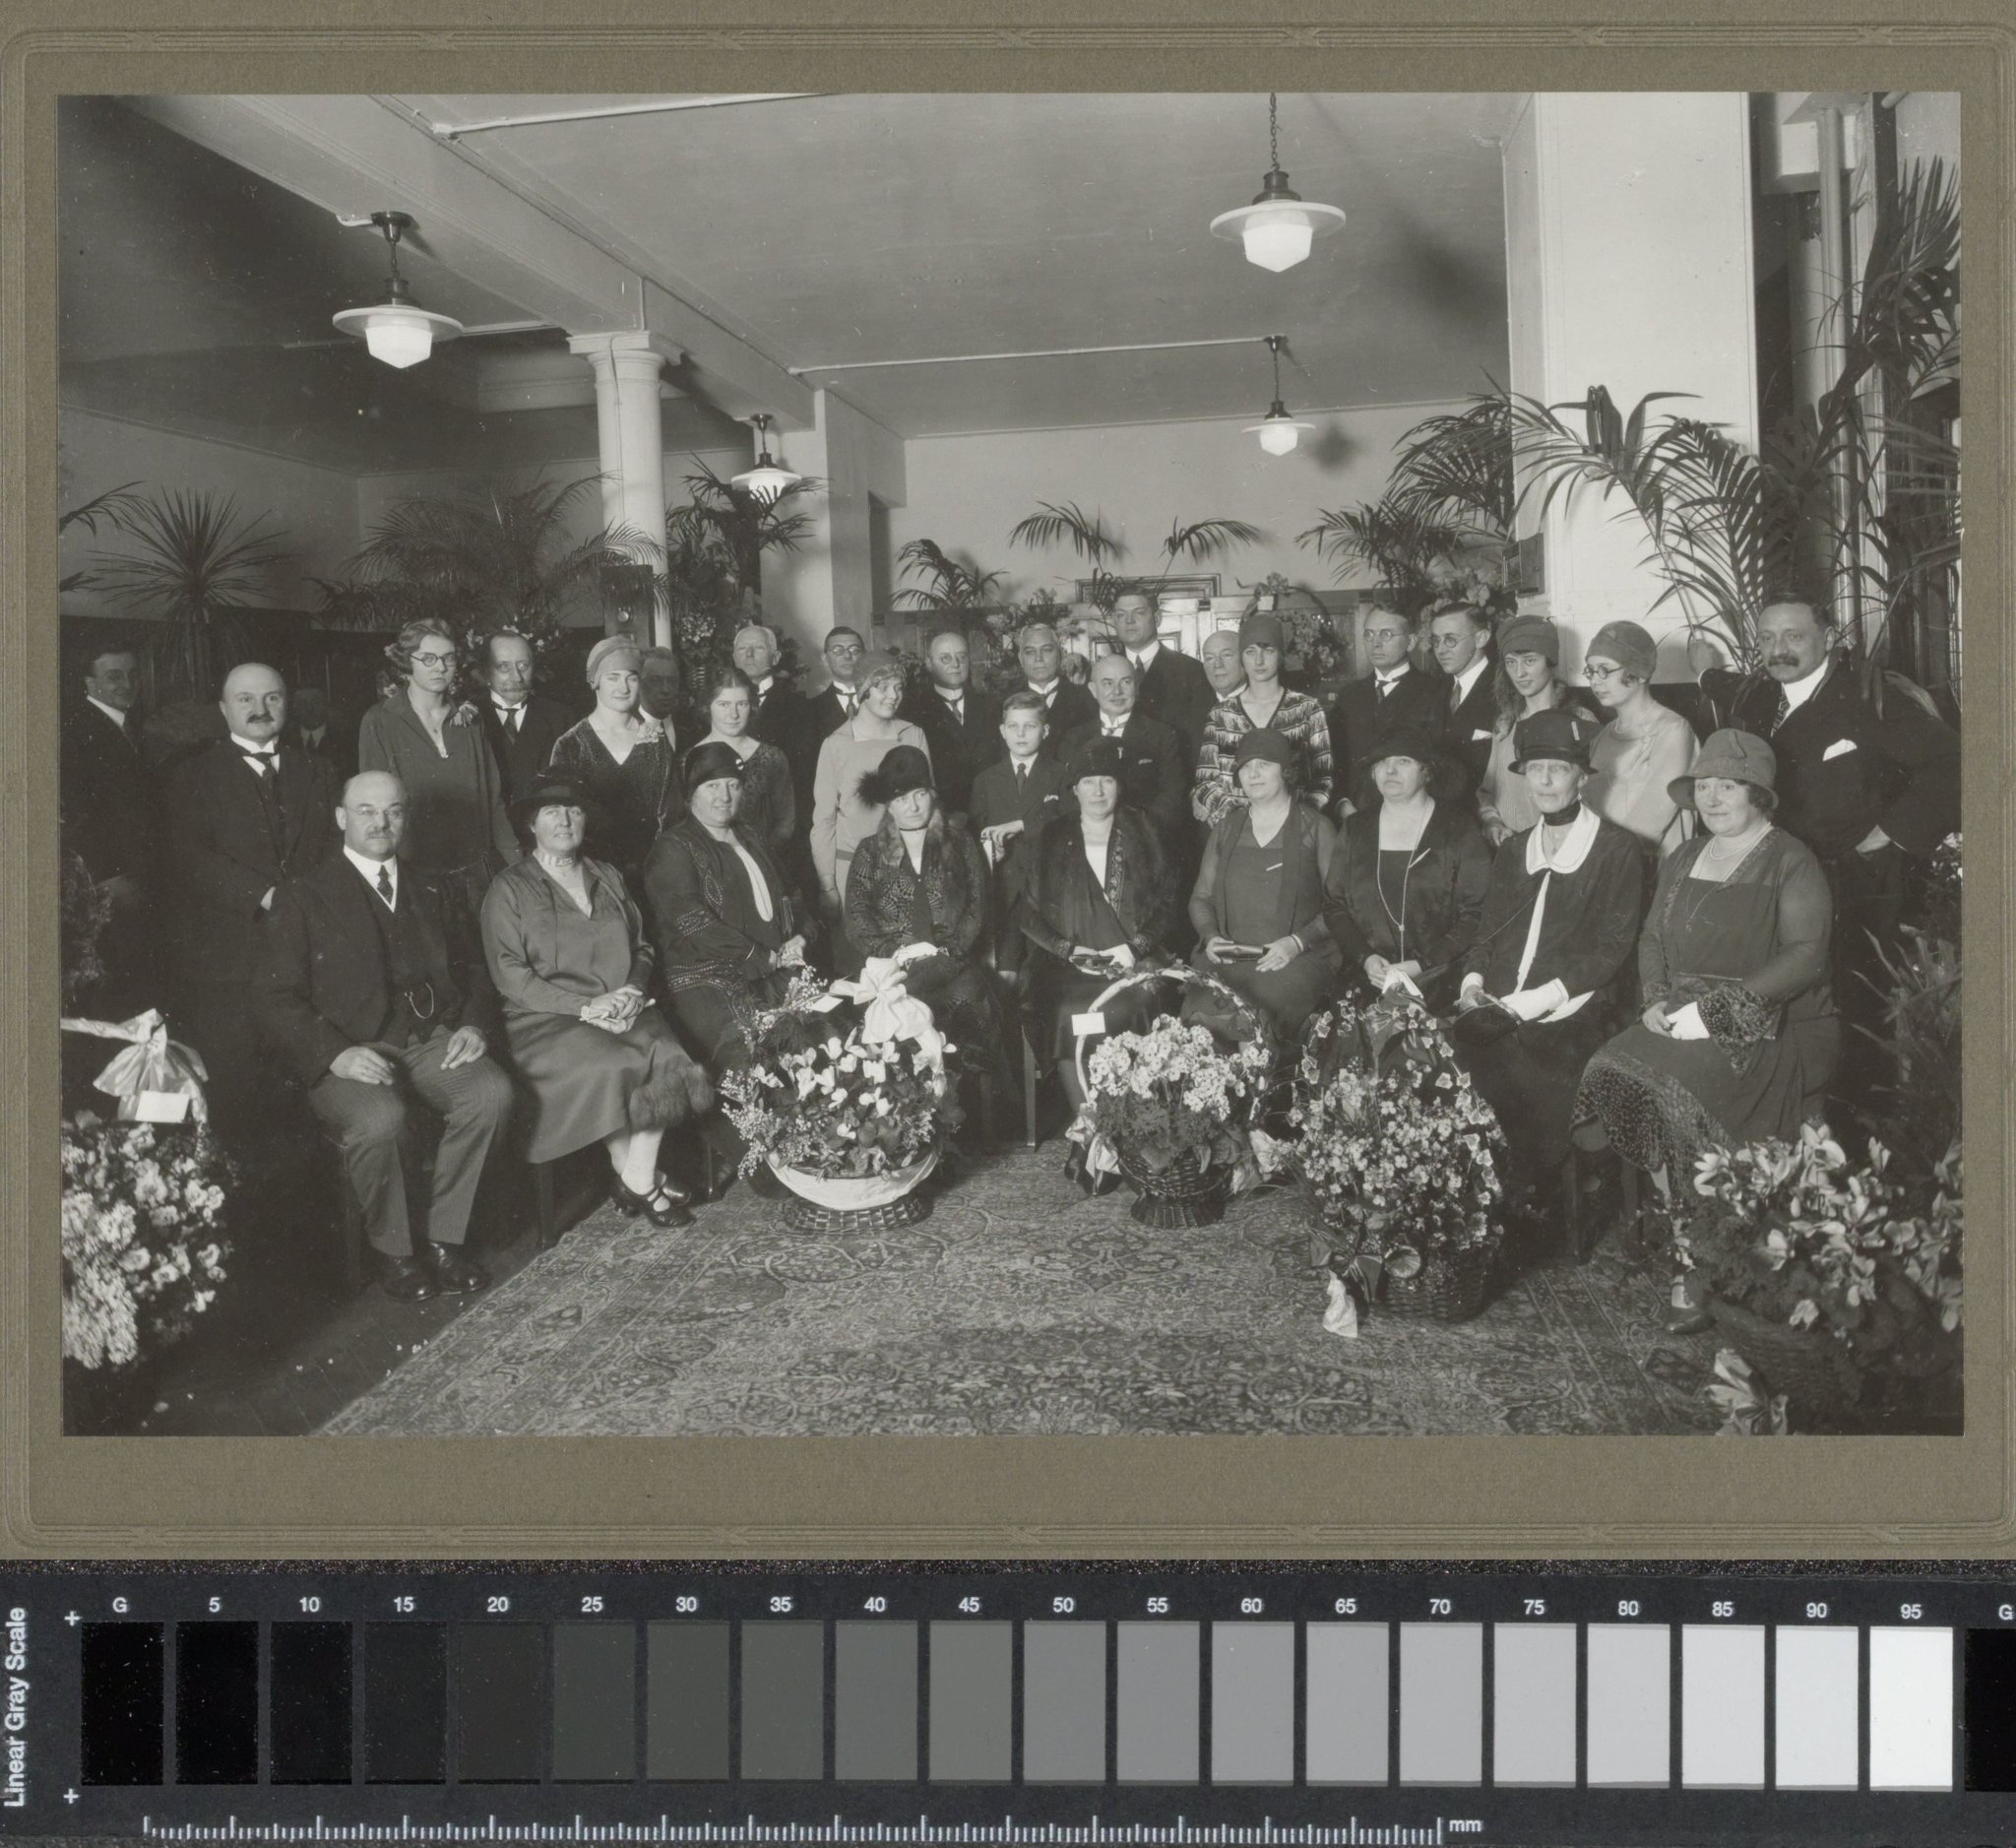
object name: photograph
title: Directie van de Handelsvereniging Amsterdam (HVA) met hun vrouwen en kinderen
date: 1929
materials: photographic support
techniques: gelatin silver print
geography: amsterdam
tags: colonial system, trade-company, director, boss (in modern industry), anonymous historical persons portrayed in a group, in a group-portrait, dutch east indies, the, amsterdam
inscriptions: inscription: ‘58378’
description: Groepsfoto van de leden van de directie van de Handelsvereniging Amsterdam met hun vrouwen en kinderen. Op de grond staan enkele bloemboeketten. Foto in het fotoalbum van de viering van het 50-jarig jubileum van de Handelsvereniging Amsterdam (HVA) in 1929.